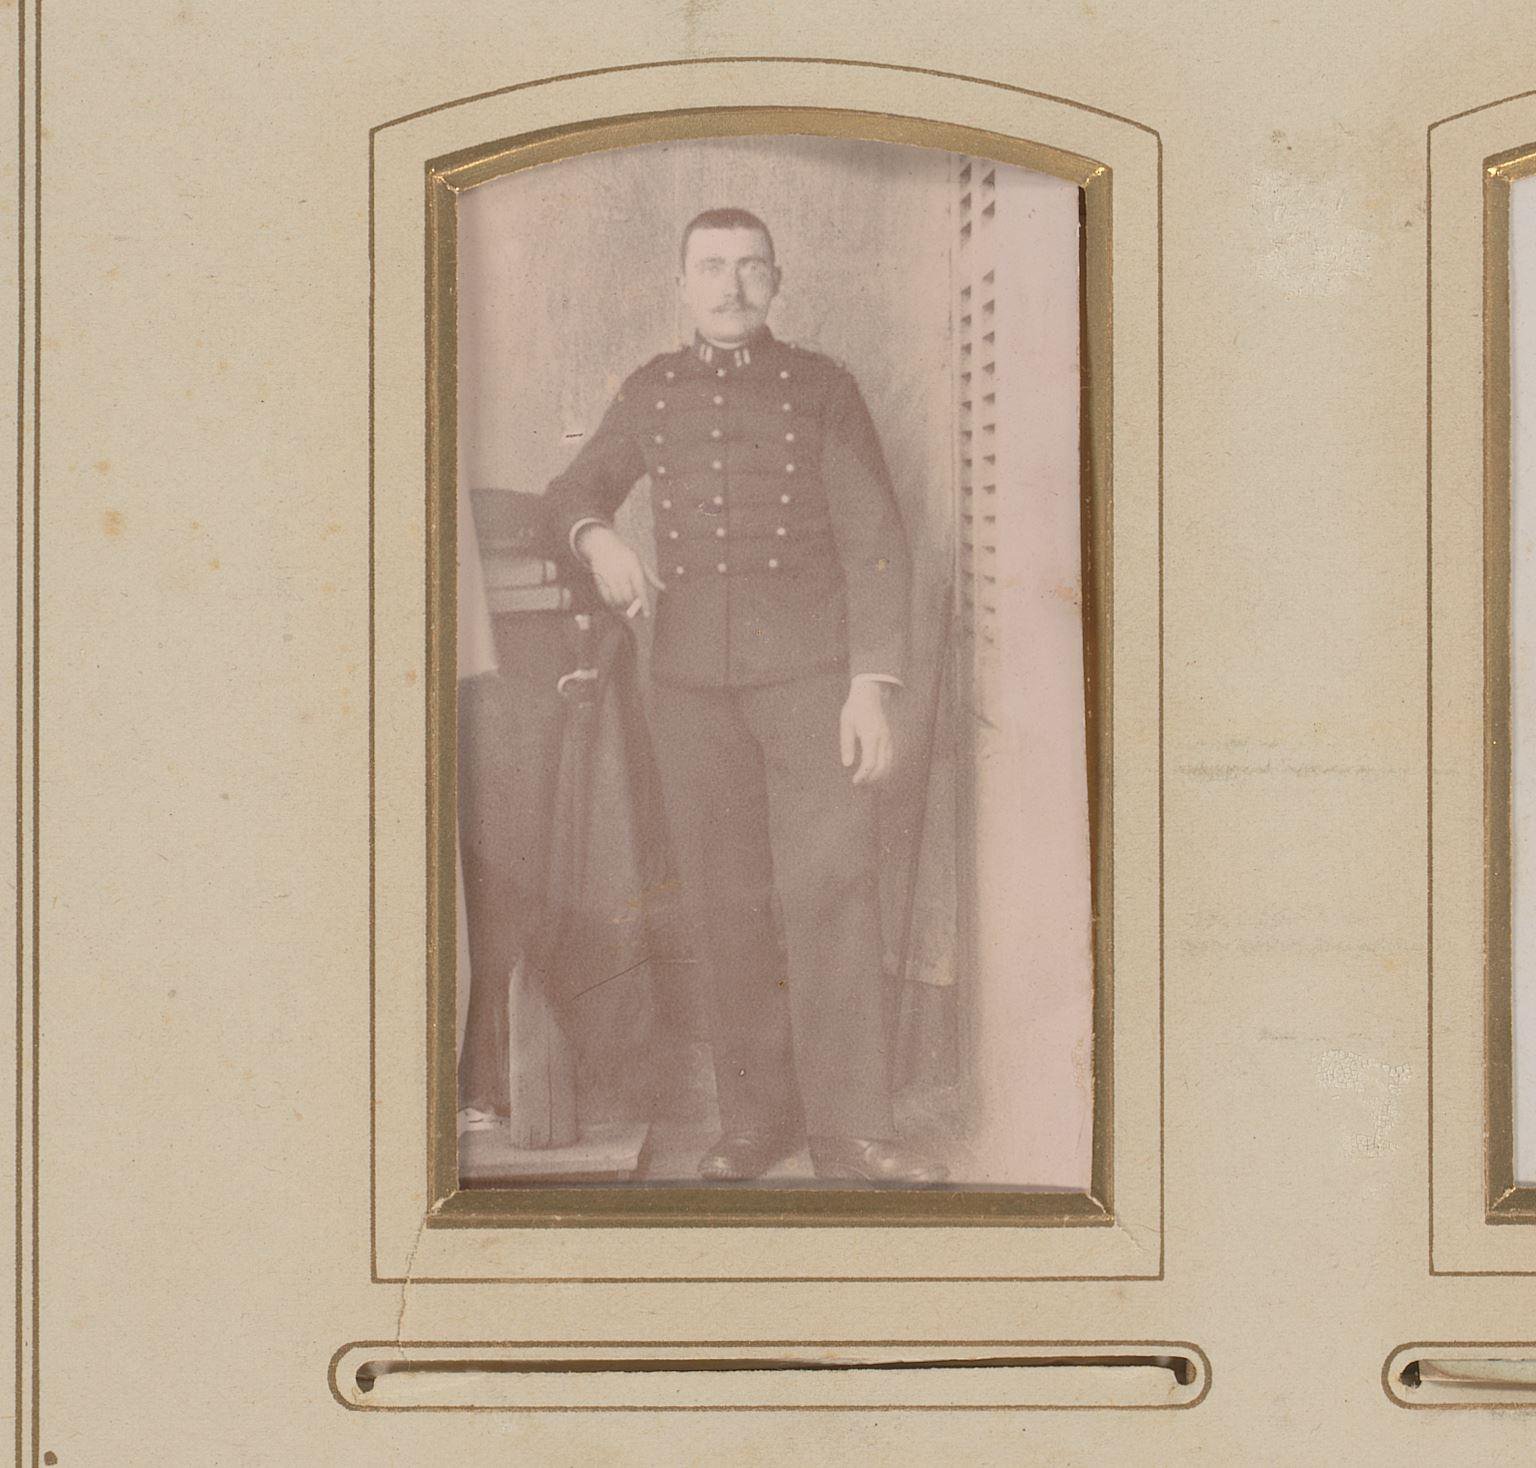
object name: album leaf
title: Portret van een man in uniform met sigaret in de hand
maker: Anonymous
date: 1882-1920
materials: cardboard, photographic support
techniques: gelatin silver print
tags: cigarette, historical persons, (military) uniforms